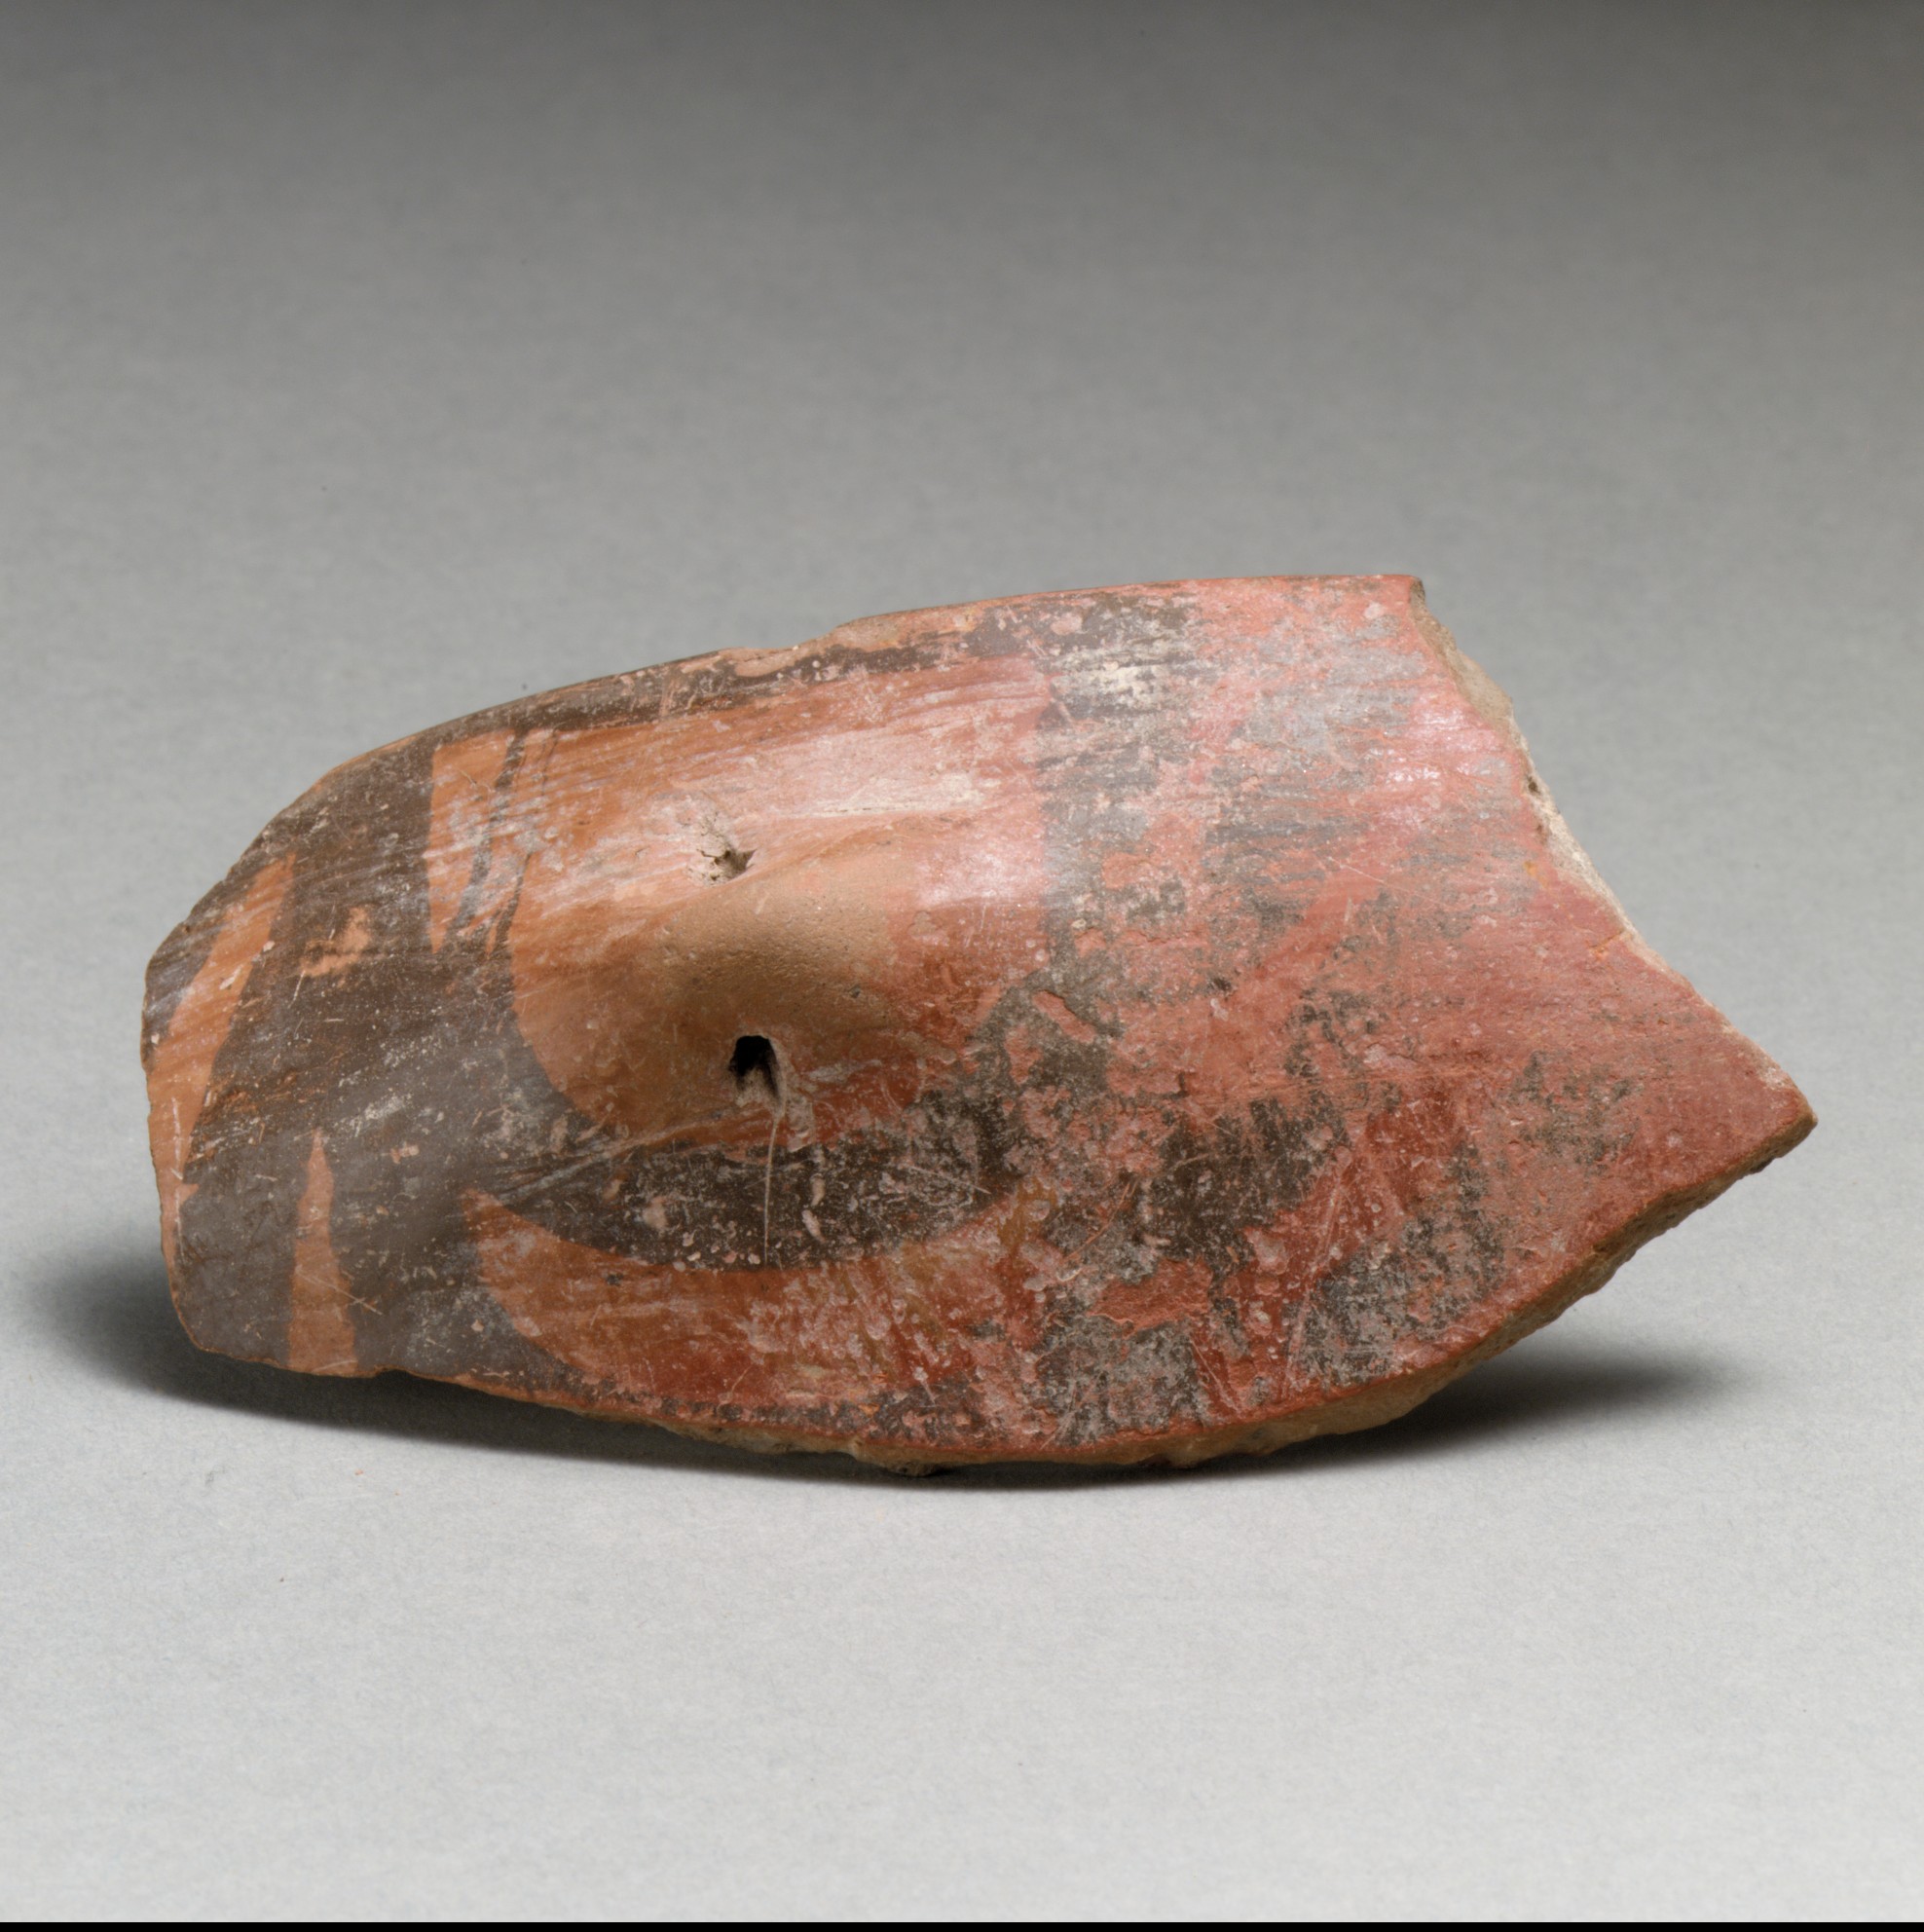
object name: vase fragment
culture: neolithic, thessaly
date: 4000-3000 BCE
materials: terracotta